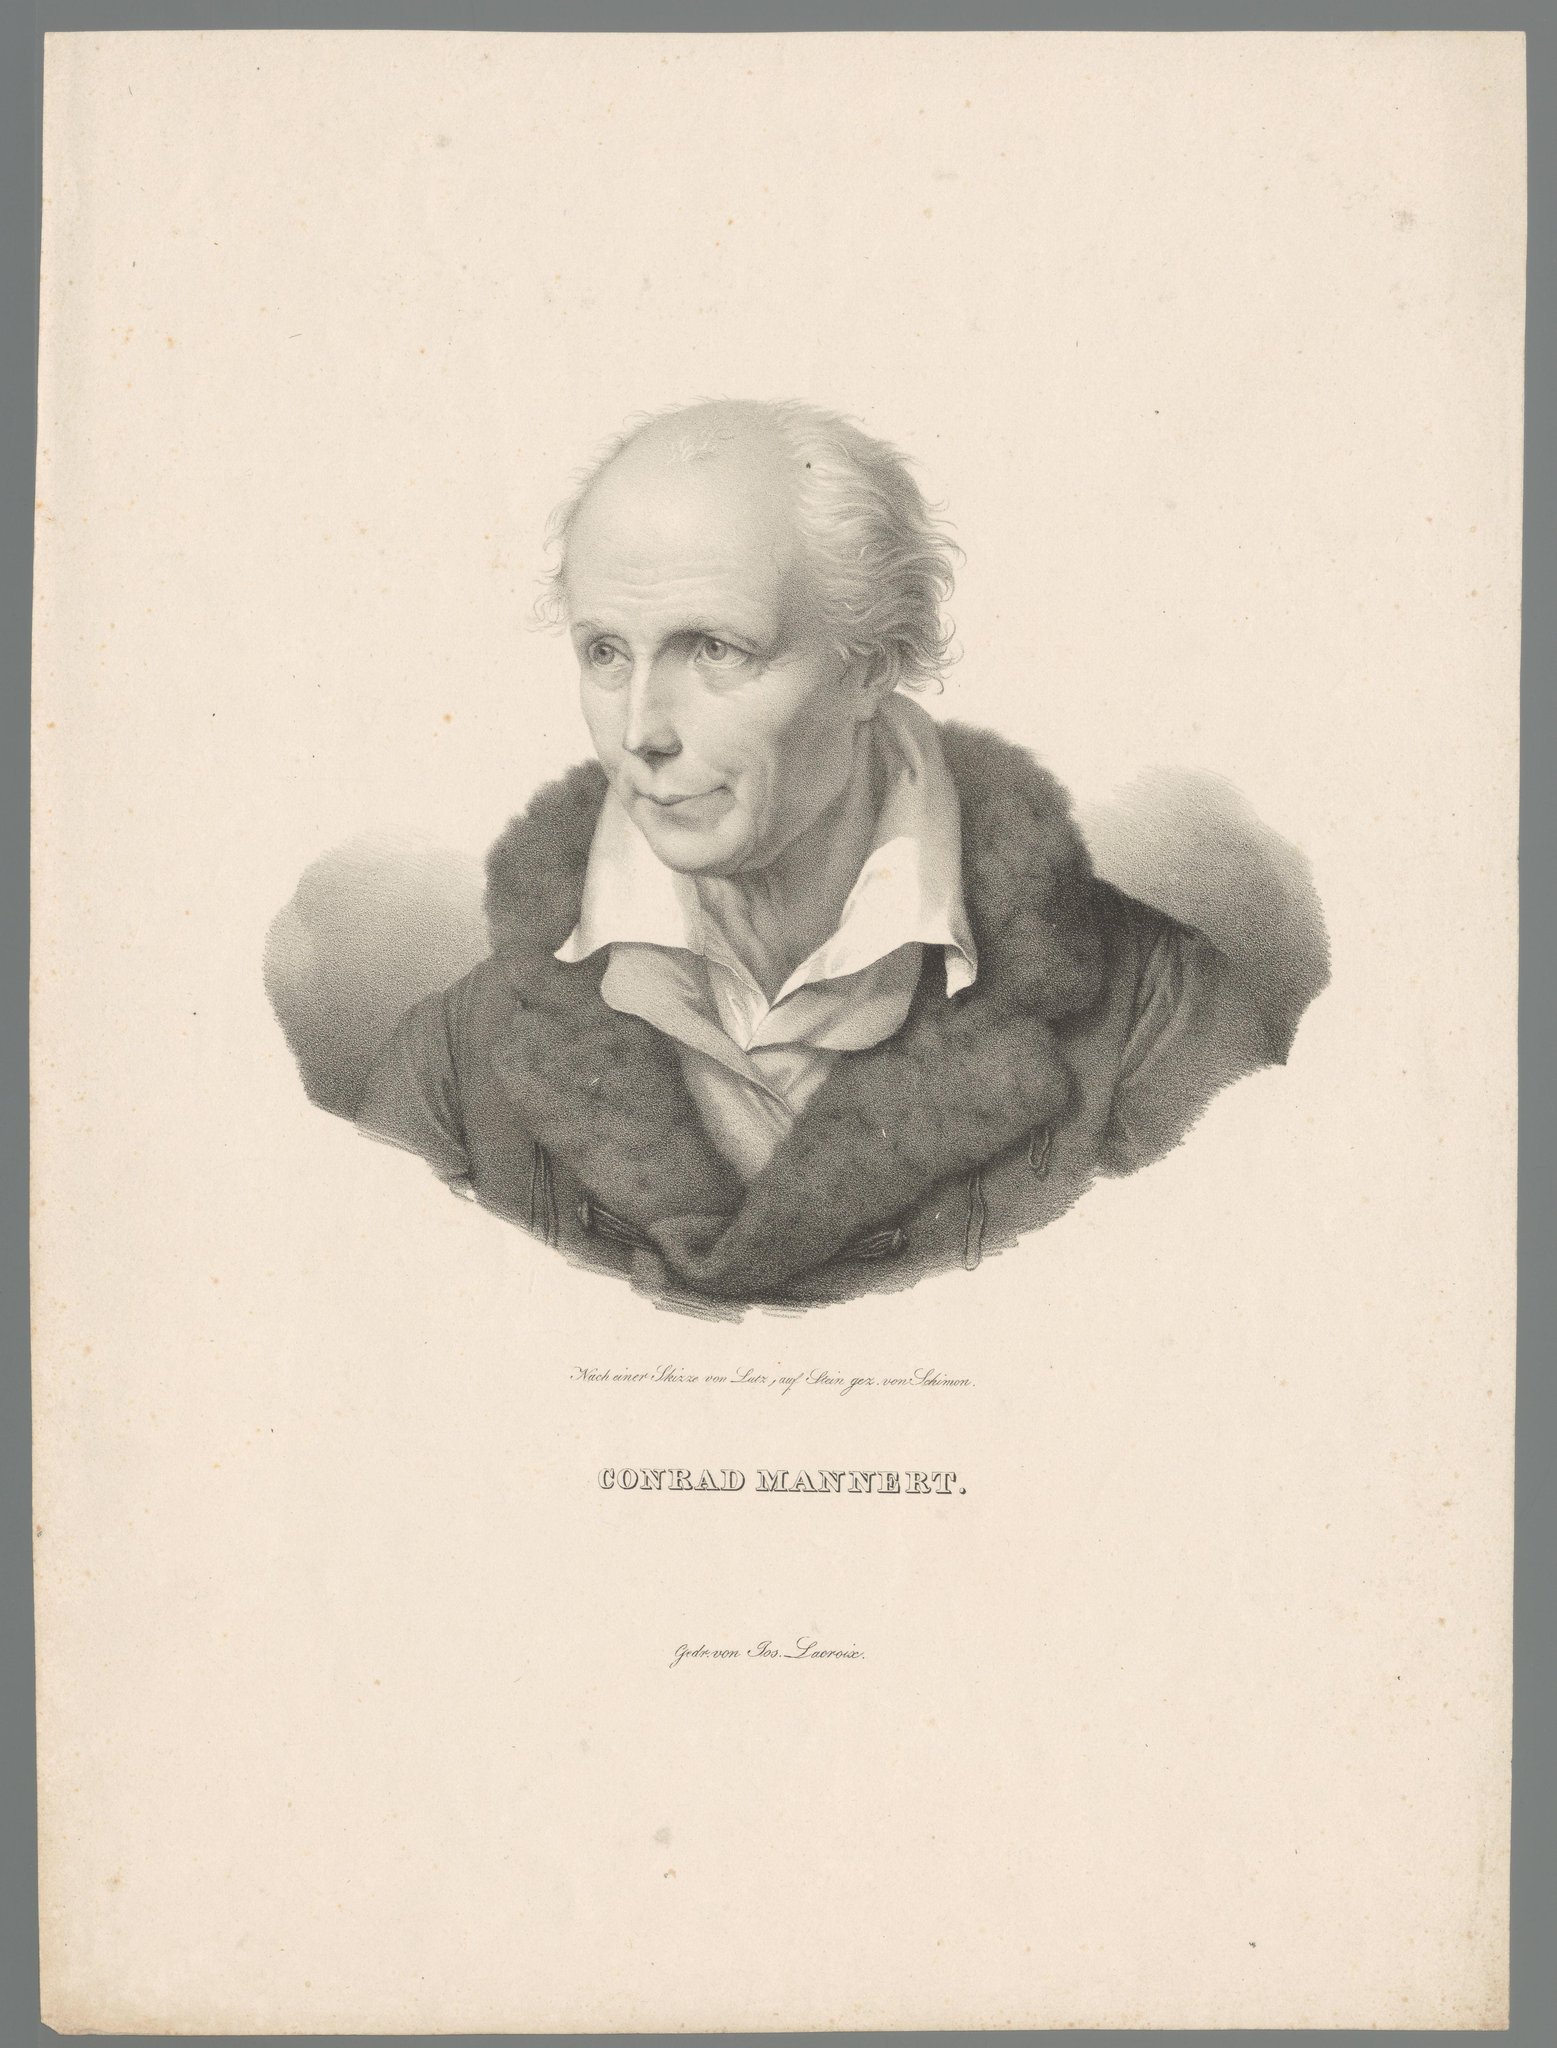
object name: print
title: Portret van Konrad Mannert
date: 1821-1835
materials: paper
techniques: lithograph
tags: history and archaeology (+ portrait of scholar, scientist), historical persons, geography (+ portrait of scholar, scientist)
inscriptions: collector's mark: Lugt 2228